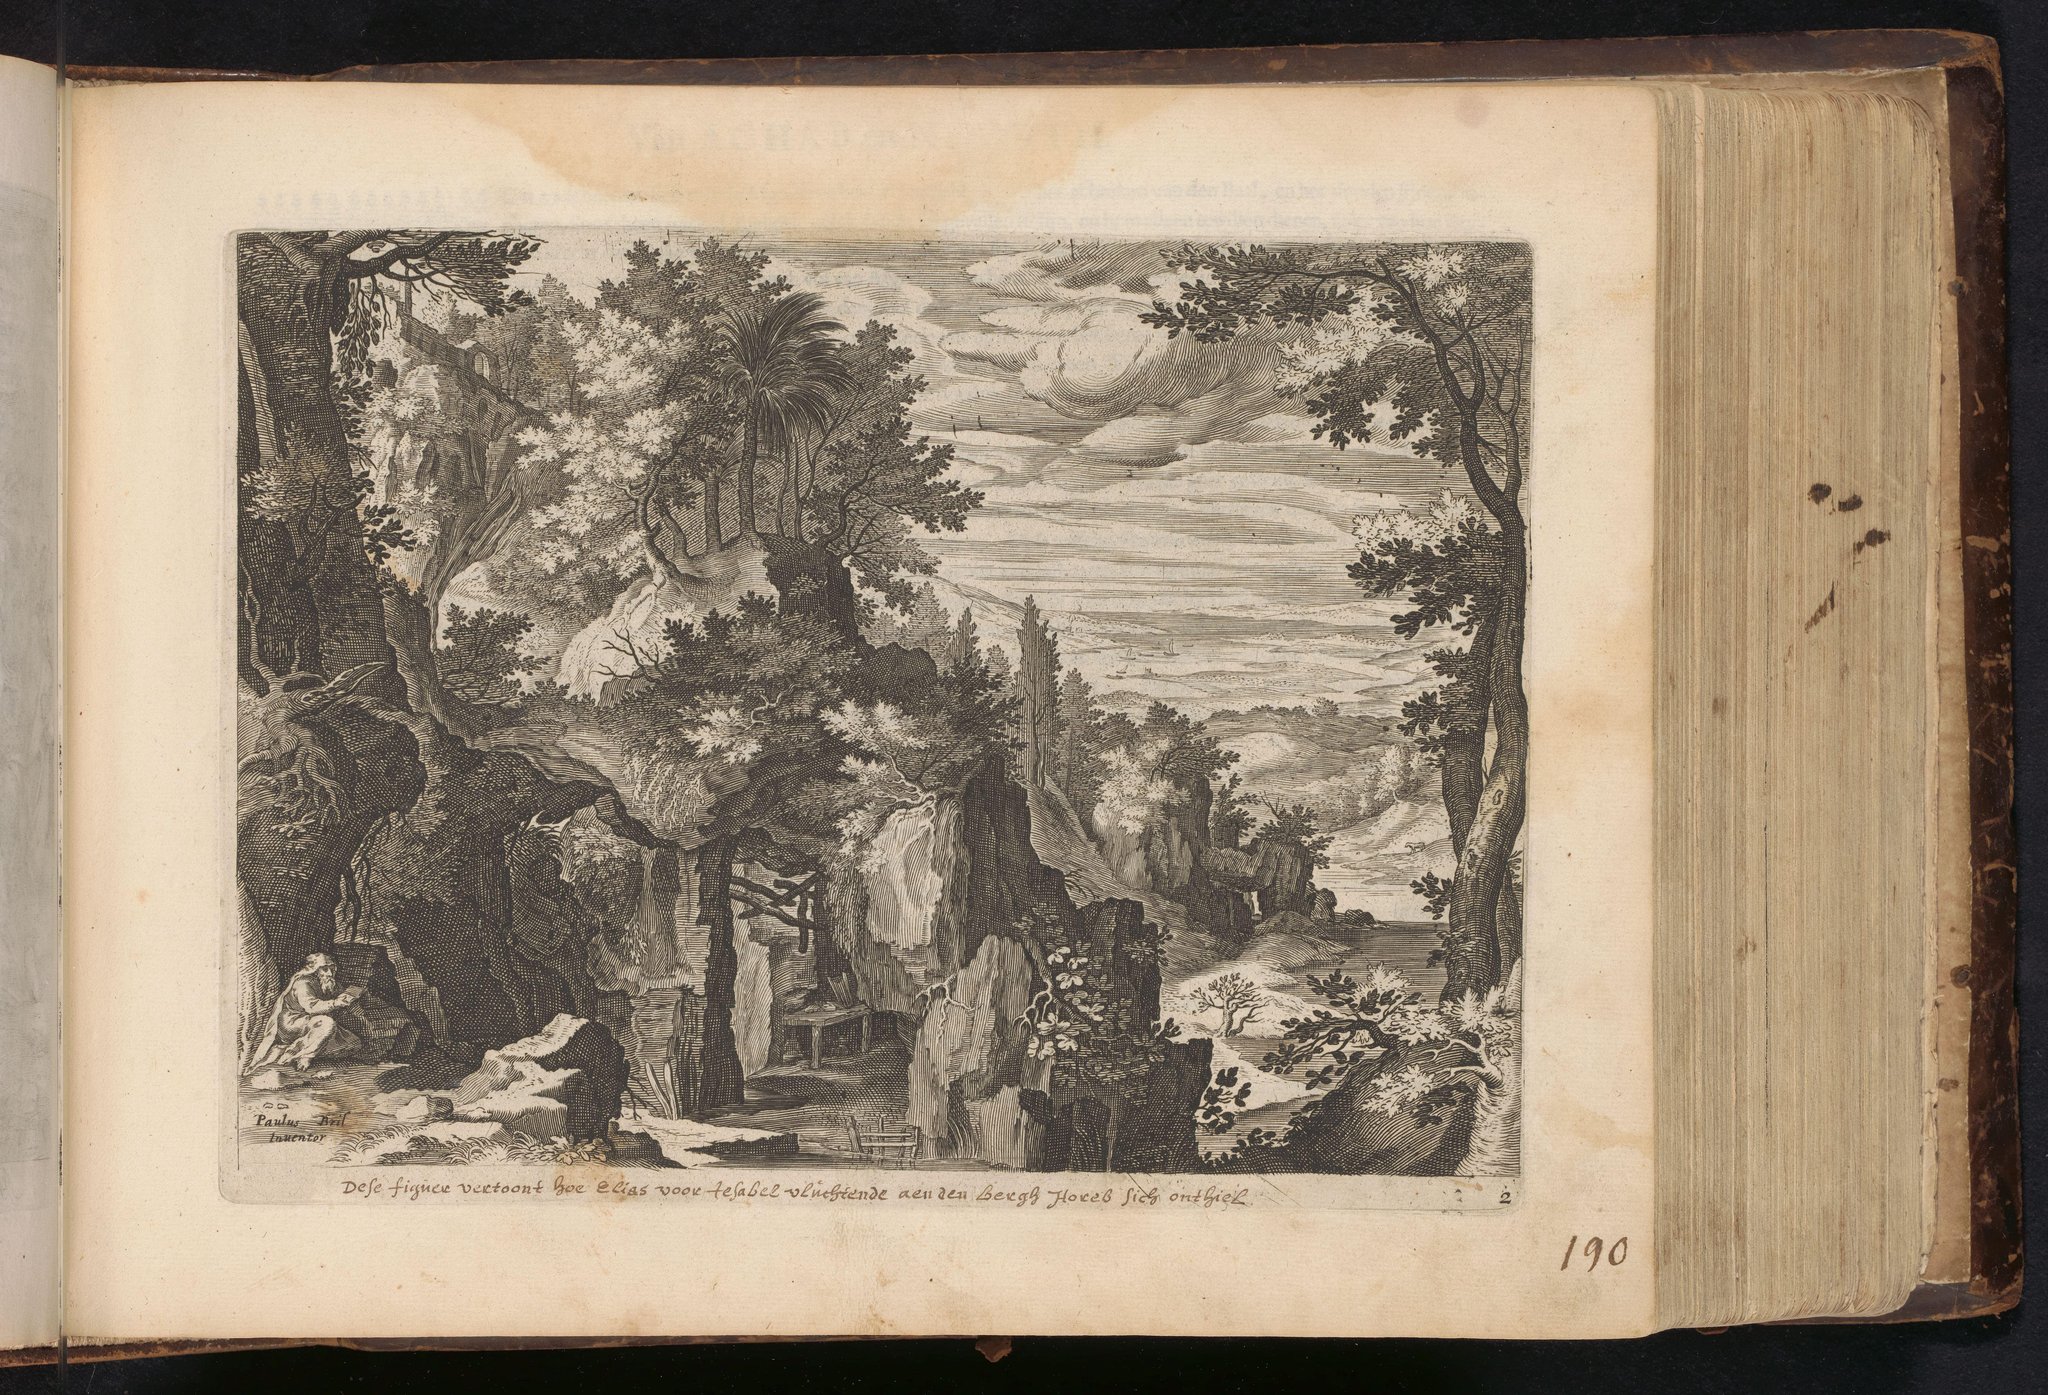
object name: album leaf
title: Den Grooten Figuer-Bibel (...)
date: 1580-1629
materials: paper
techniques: engraving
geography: amsterdam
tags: forest, wood, anchorite, hermit, mountains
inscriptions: number: ‘190’, inscription: ‘Dese figure vertoont hoe Elias voor Jesabel vluchtende aen den bergh Horeb sich onthiel’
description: Berglandschap met rechtsvoor een kluizenaar, lezend in boek. In het midden zijn hut. Rechtsonder genummerd: 2. In de context van het album en volgens het onderschrift wordt de kluizenaar geïnterpreteerd als Elia. Deze prent maakt deel uit van een album.